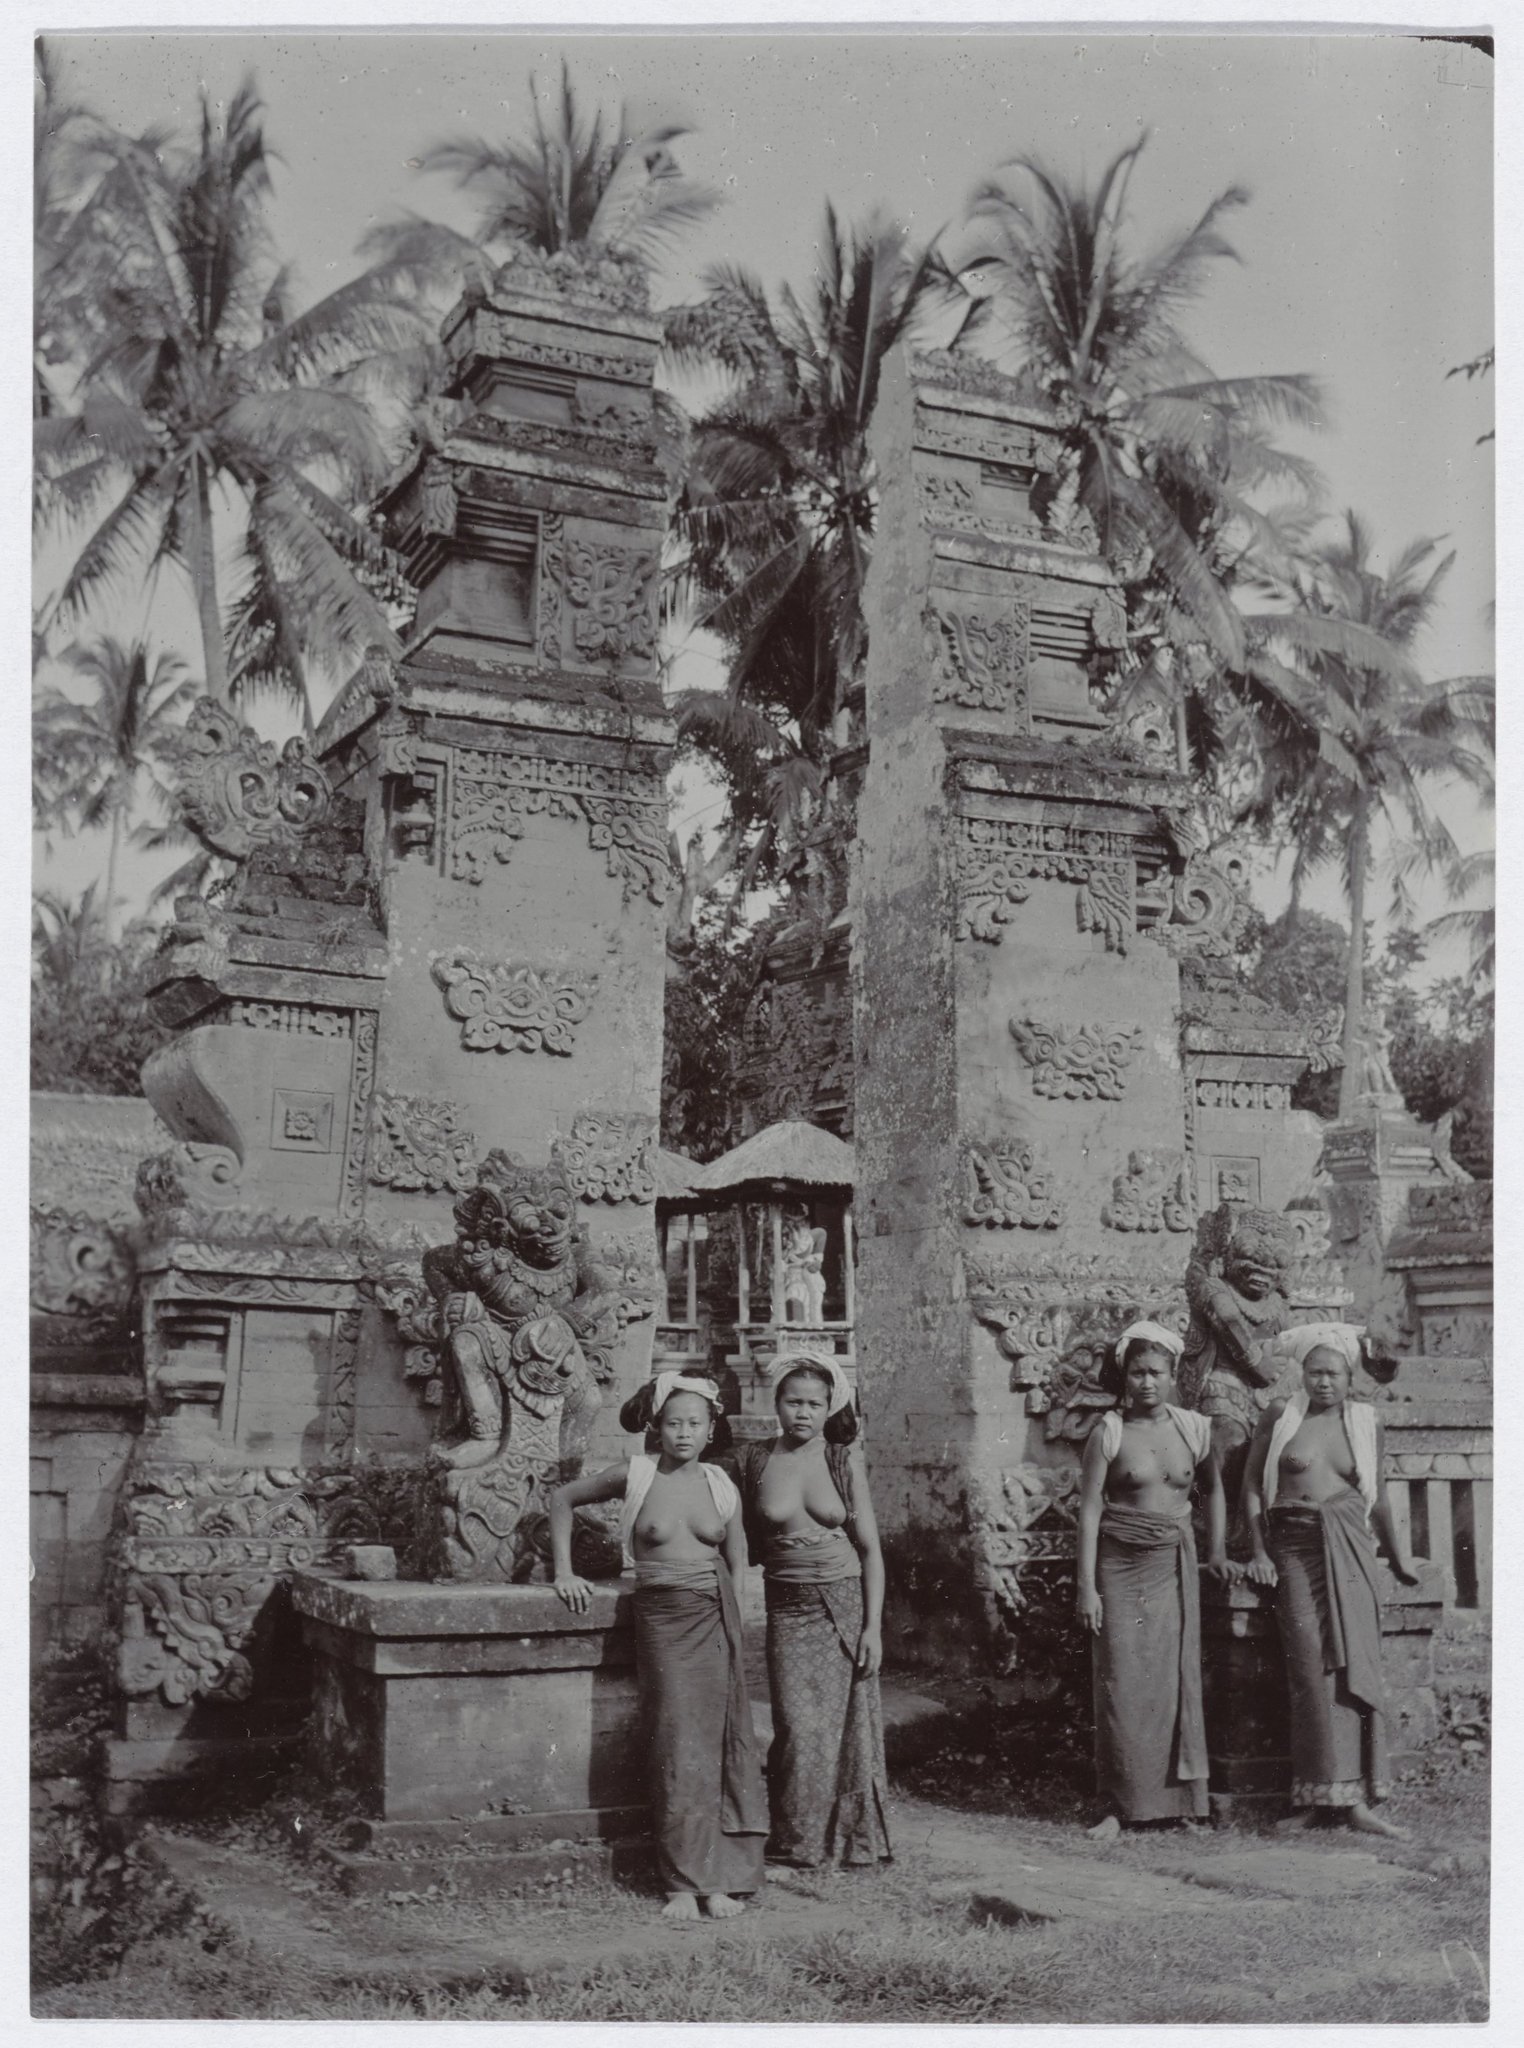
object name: photograph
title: Vier jonge dames in ontbloot bovenlichaam poserend voor een tempelpoort op Zuid-Bali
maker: johanna hermina marmelstein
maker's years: 1897-1990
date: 1900-1915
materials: paper, photographic support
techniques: albumen print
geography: jakarta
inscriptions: annotation: ‘3. Zuid-Bali. Buitenpoort Poera tusschen Badoeng en Taba nau met 4 vrouwen op voorgrond t.w. Lemek, Roepeg, Tjebloek, Roebik, de schoonste der aanwezige dames door mijn vrouw uitgezocht. Deze wilden zich in het natuinaal costuum alleen laten fotograferen op voorwaarden; 1. dat ik de foto's niet in den handel bracht of verkocht. 2. dat elke delinquente een afdruk kreeg.’